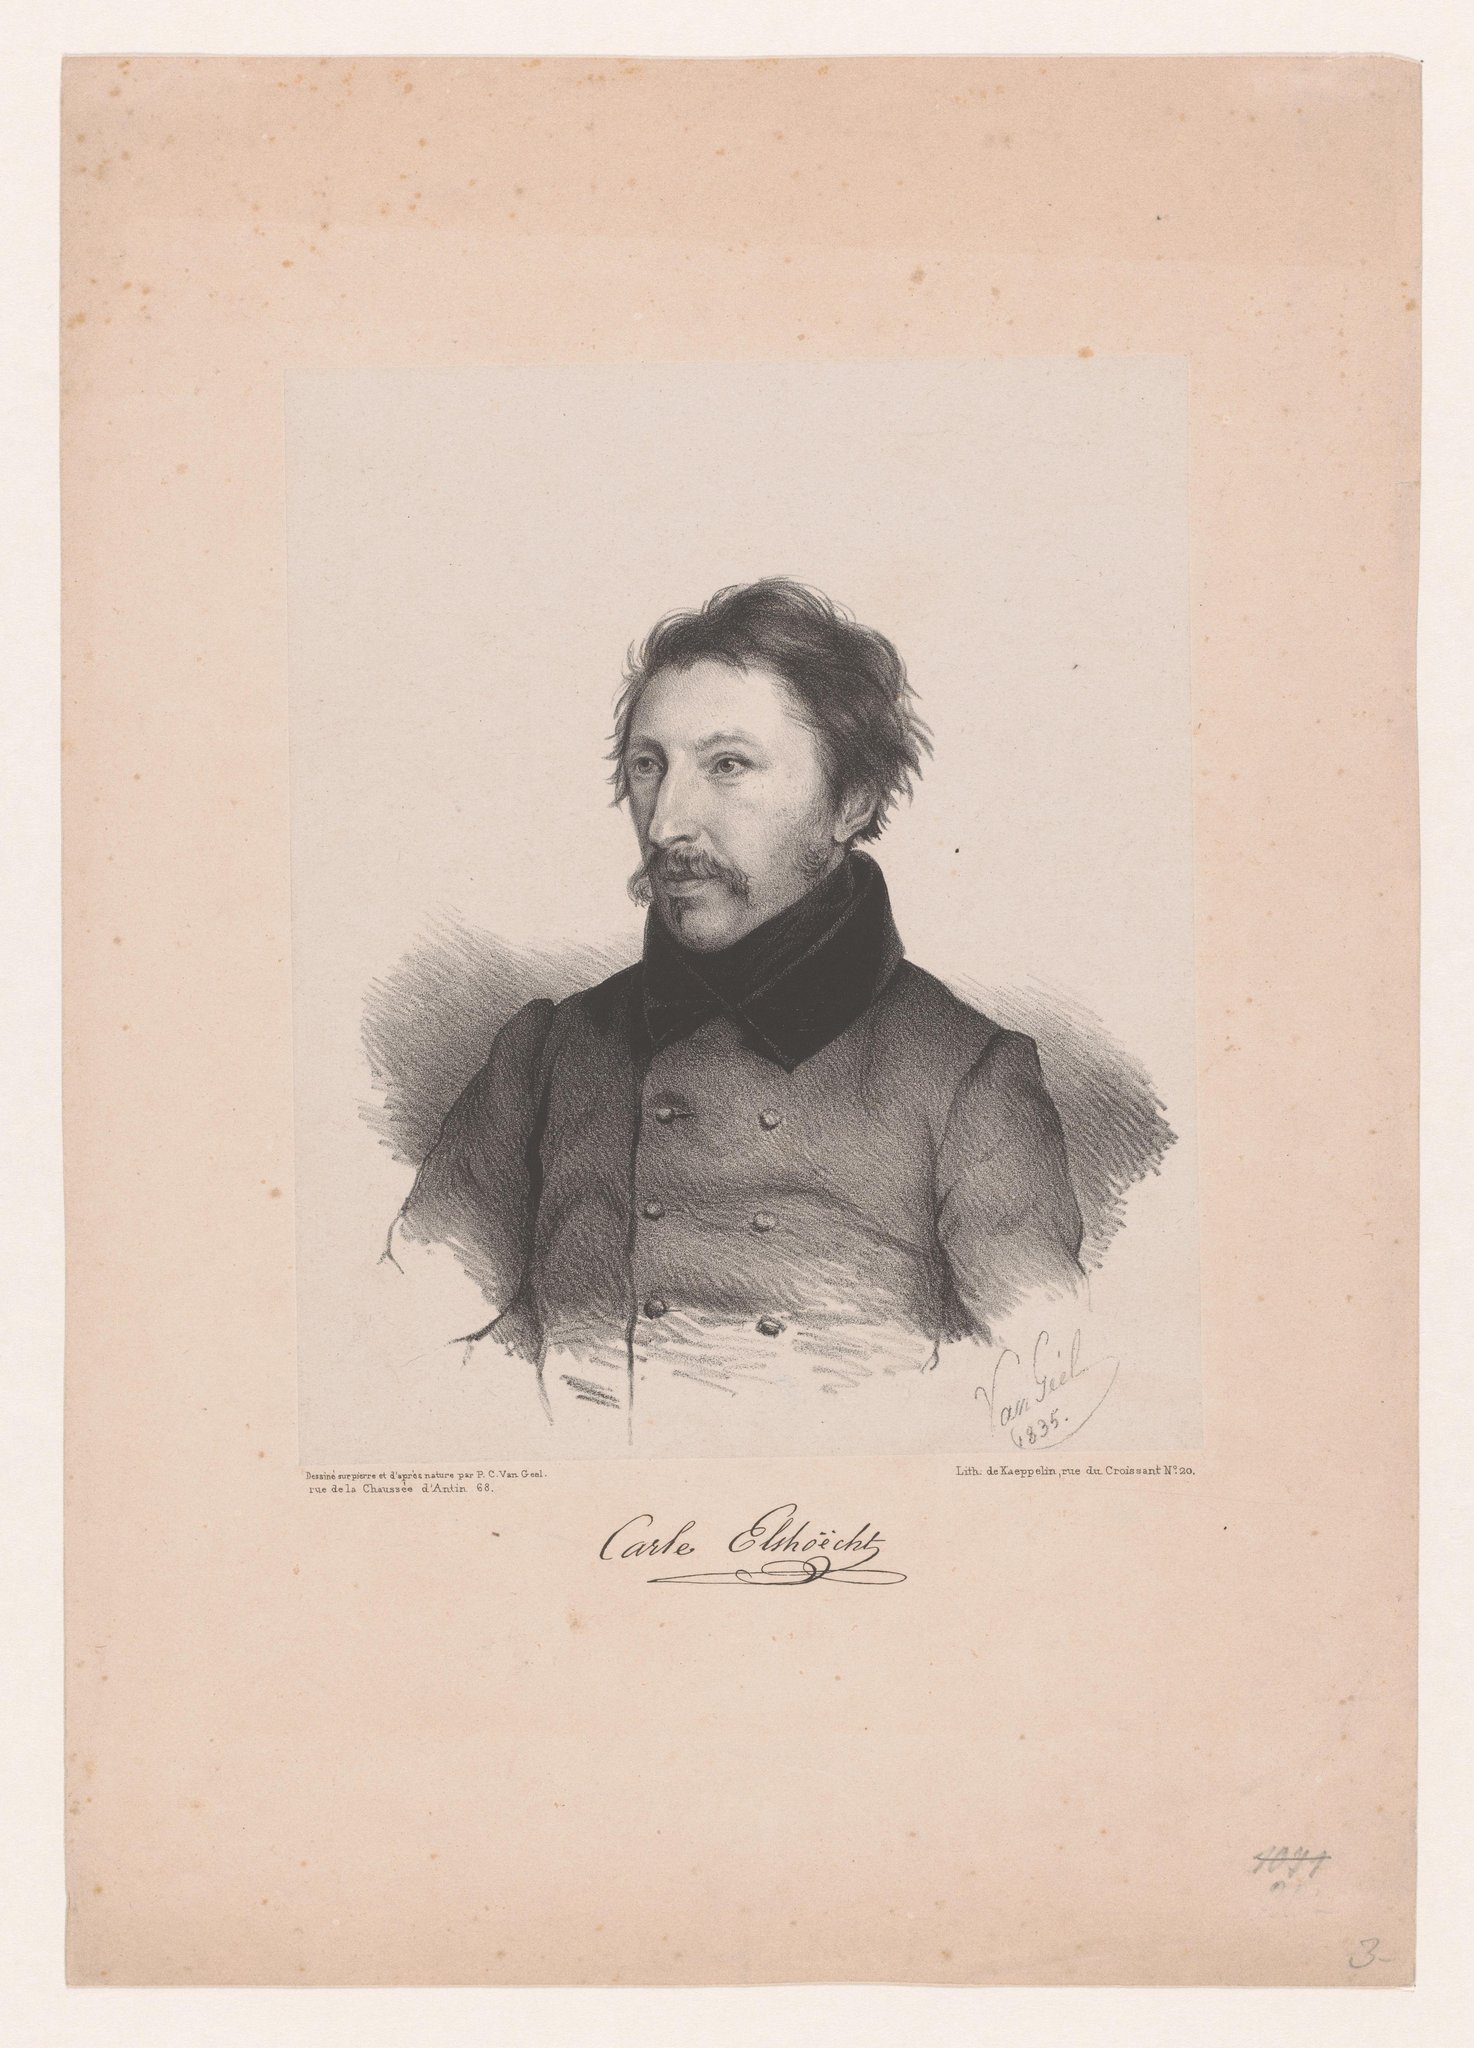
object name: print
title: Portret van Carle Elshöecht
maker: p.c. van geel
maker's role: print maker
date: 1835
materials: paper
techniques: lithograph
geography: paris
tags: historical persons (+ (full) bust portrait)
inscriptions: collector's mark: Lugt 2228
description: De geportretteerde kijkt naar links. Hij draagt een jas met dubbele knopen. Onder het portret zijn signatuur.